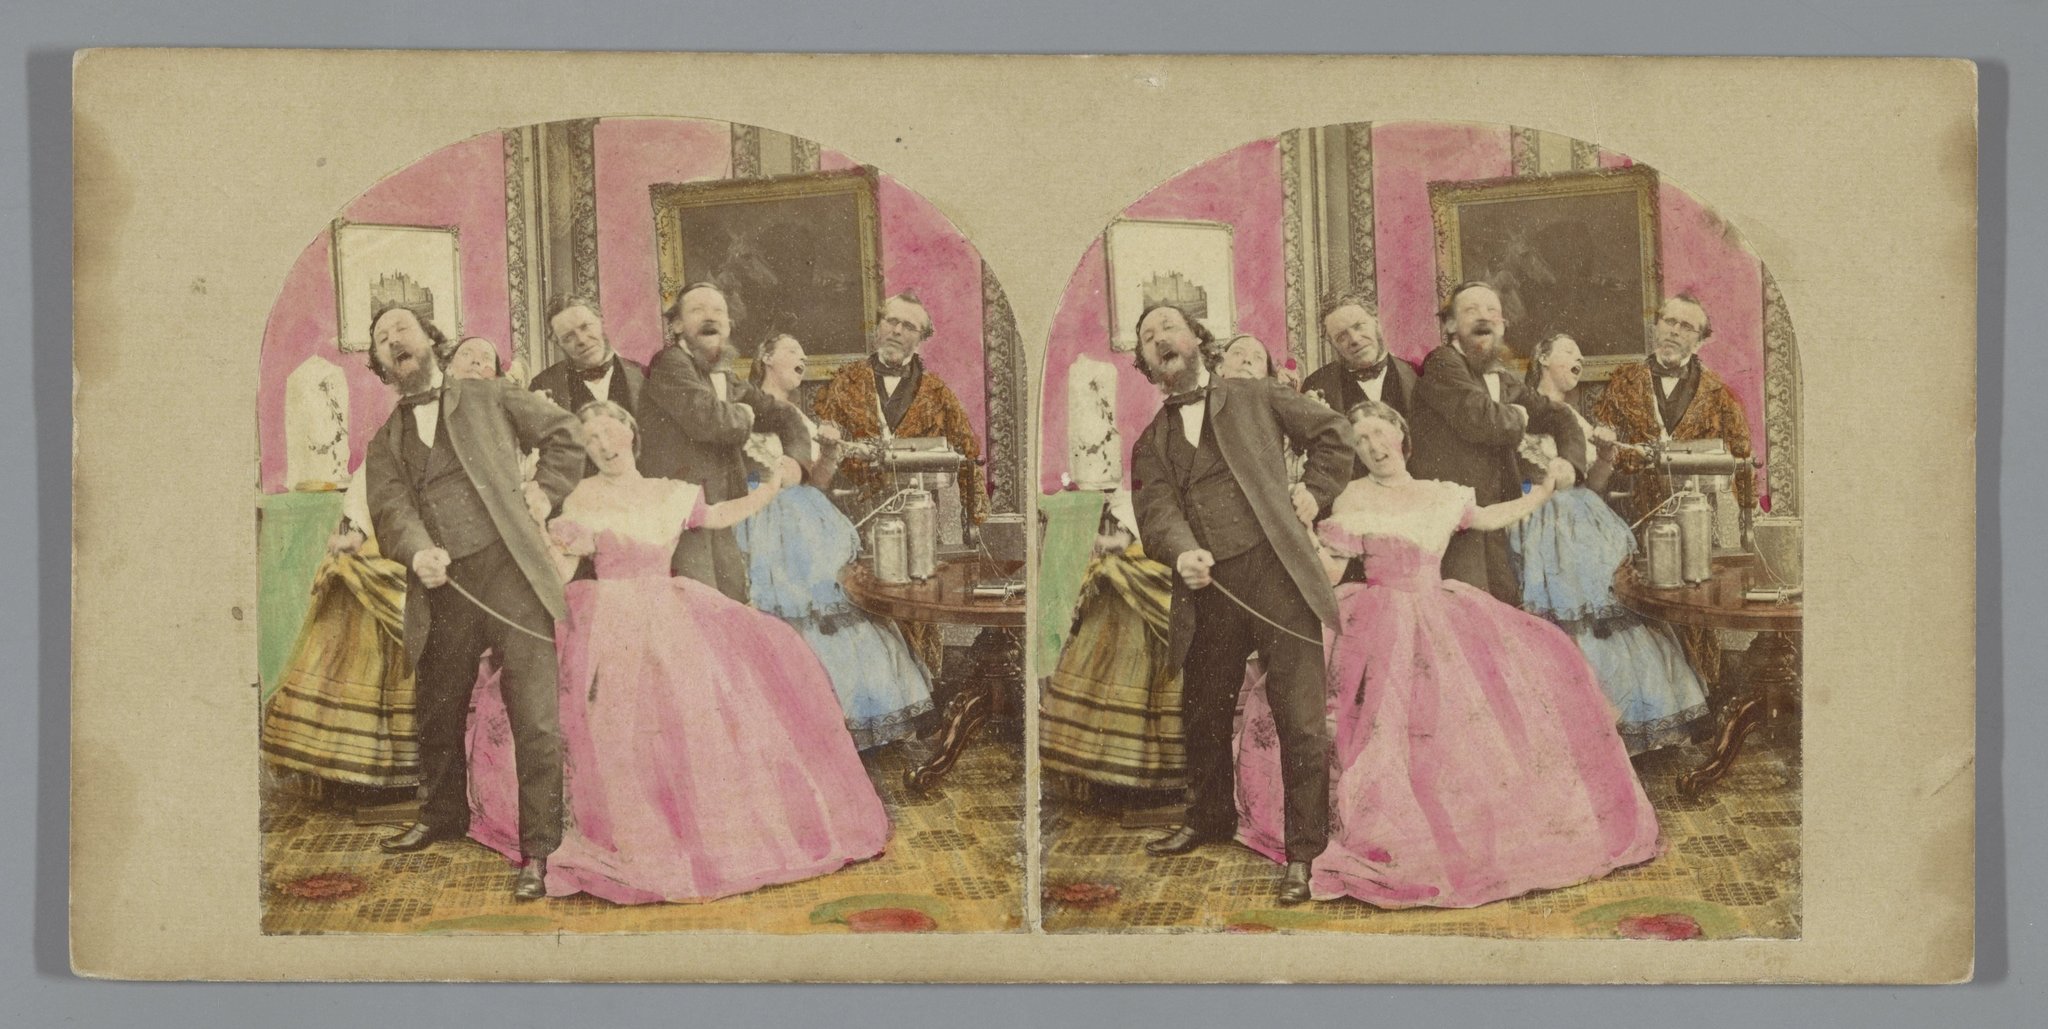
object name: stereograph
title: Wetenschappelijke experimenten uitgevoerd in een huiskamer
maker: Anonymous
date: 1852-1863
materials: cardboard, paper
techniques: albumen print, hand coloring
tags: drawing-room, 'salon', experiment, test ~ science and technology